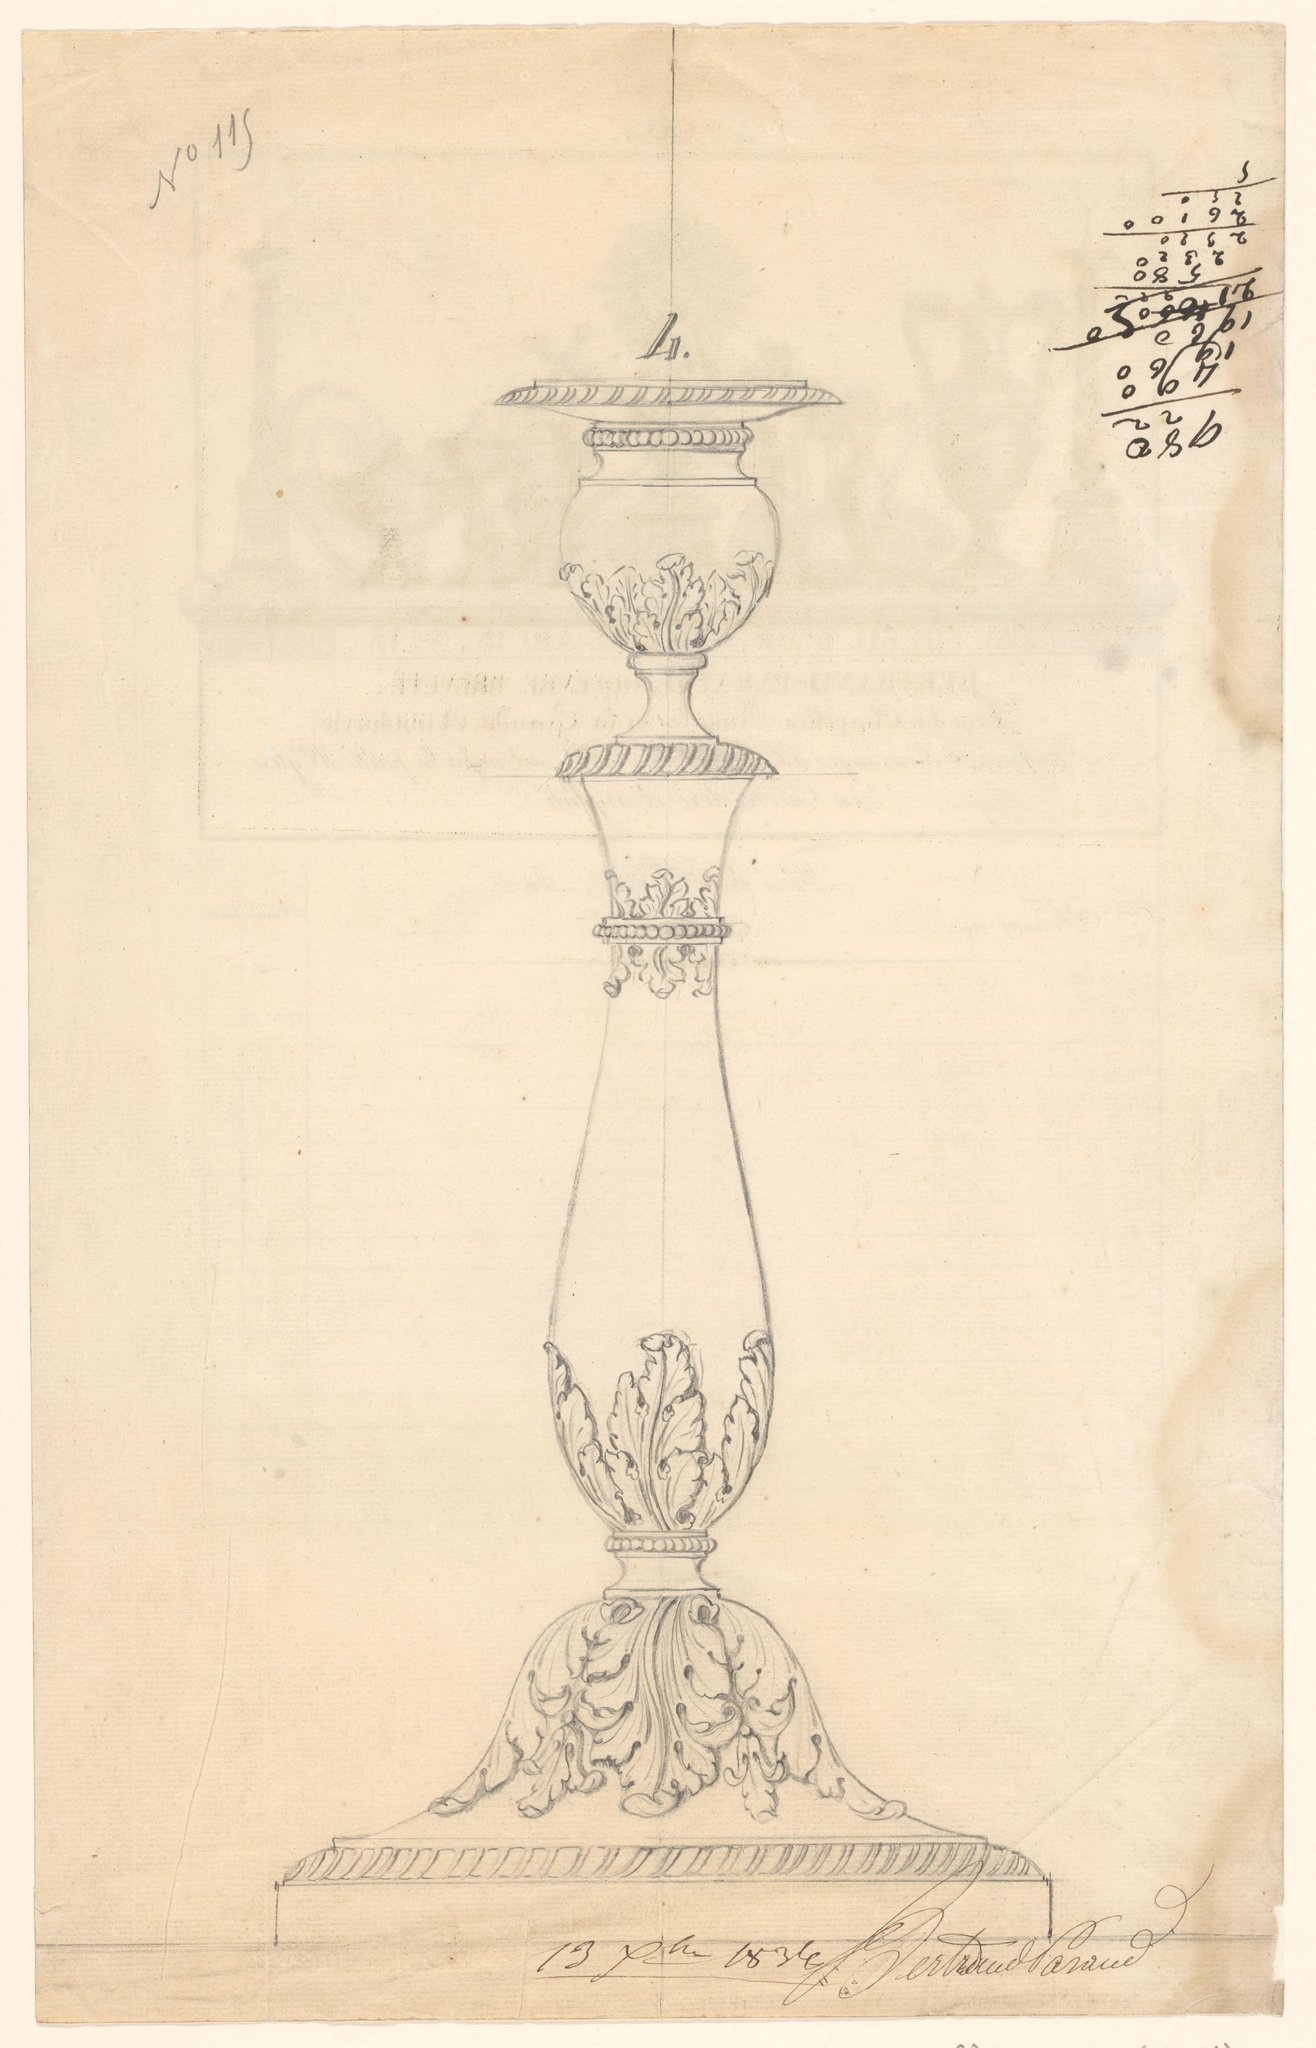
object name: design drawing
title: Ontwerp voor een kandelaar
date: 1834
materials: graphite, paper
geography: paris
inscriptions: watermark, signature and date: ‘13 Xbre 1834 F Bertrand Paraud’, number: ‘No. 115’, number: ‘4’, inscription: ‘Berekeningen in pen en bruine inkt.’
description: Getekend op de achterzijde van gegraveerd factuurpapier van Bertrand-Paraud (RP-T-2019-349(V)).